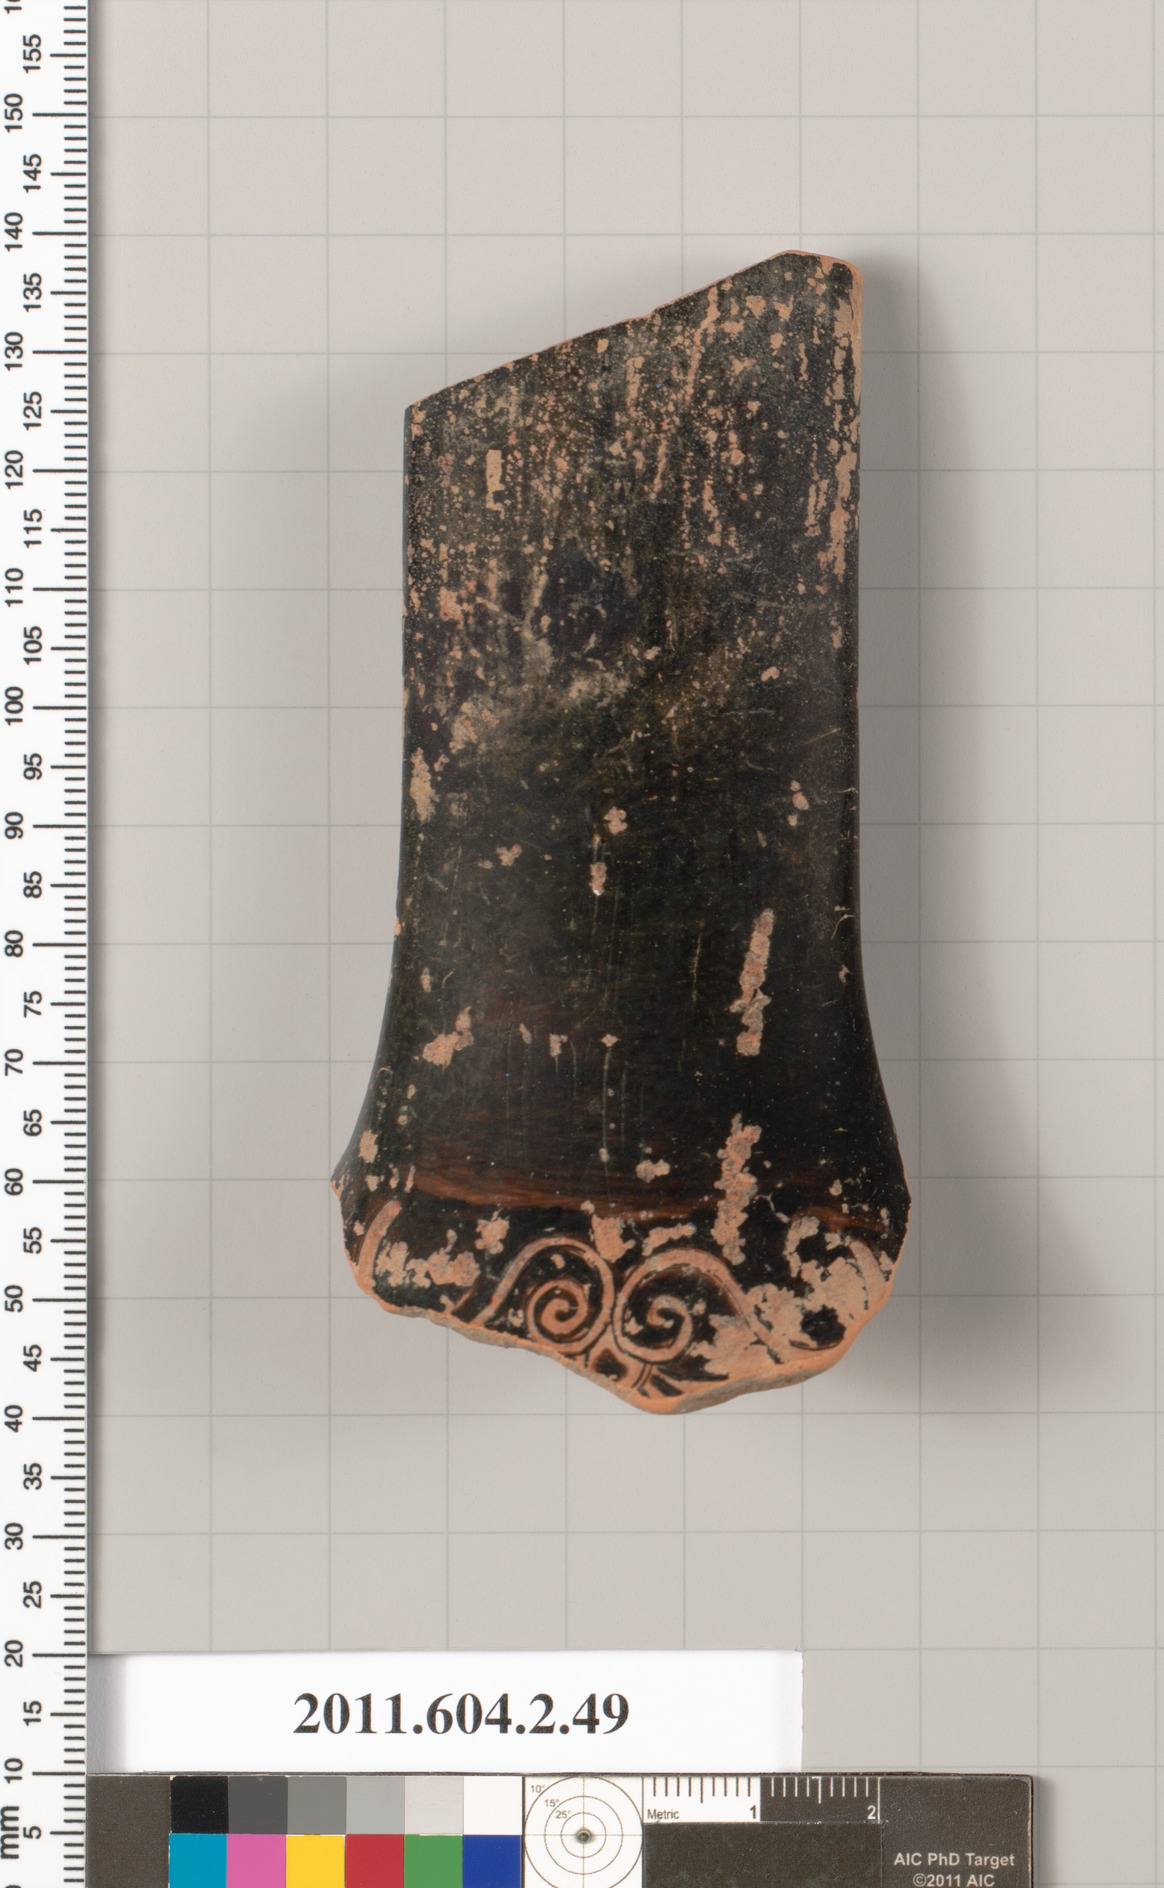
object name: pelike fragment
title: Terracotta fragment of a pelike (jar)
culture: greek, attic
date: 510-490 BCE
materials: terracotta